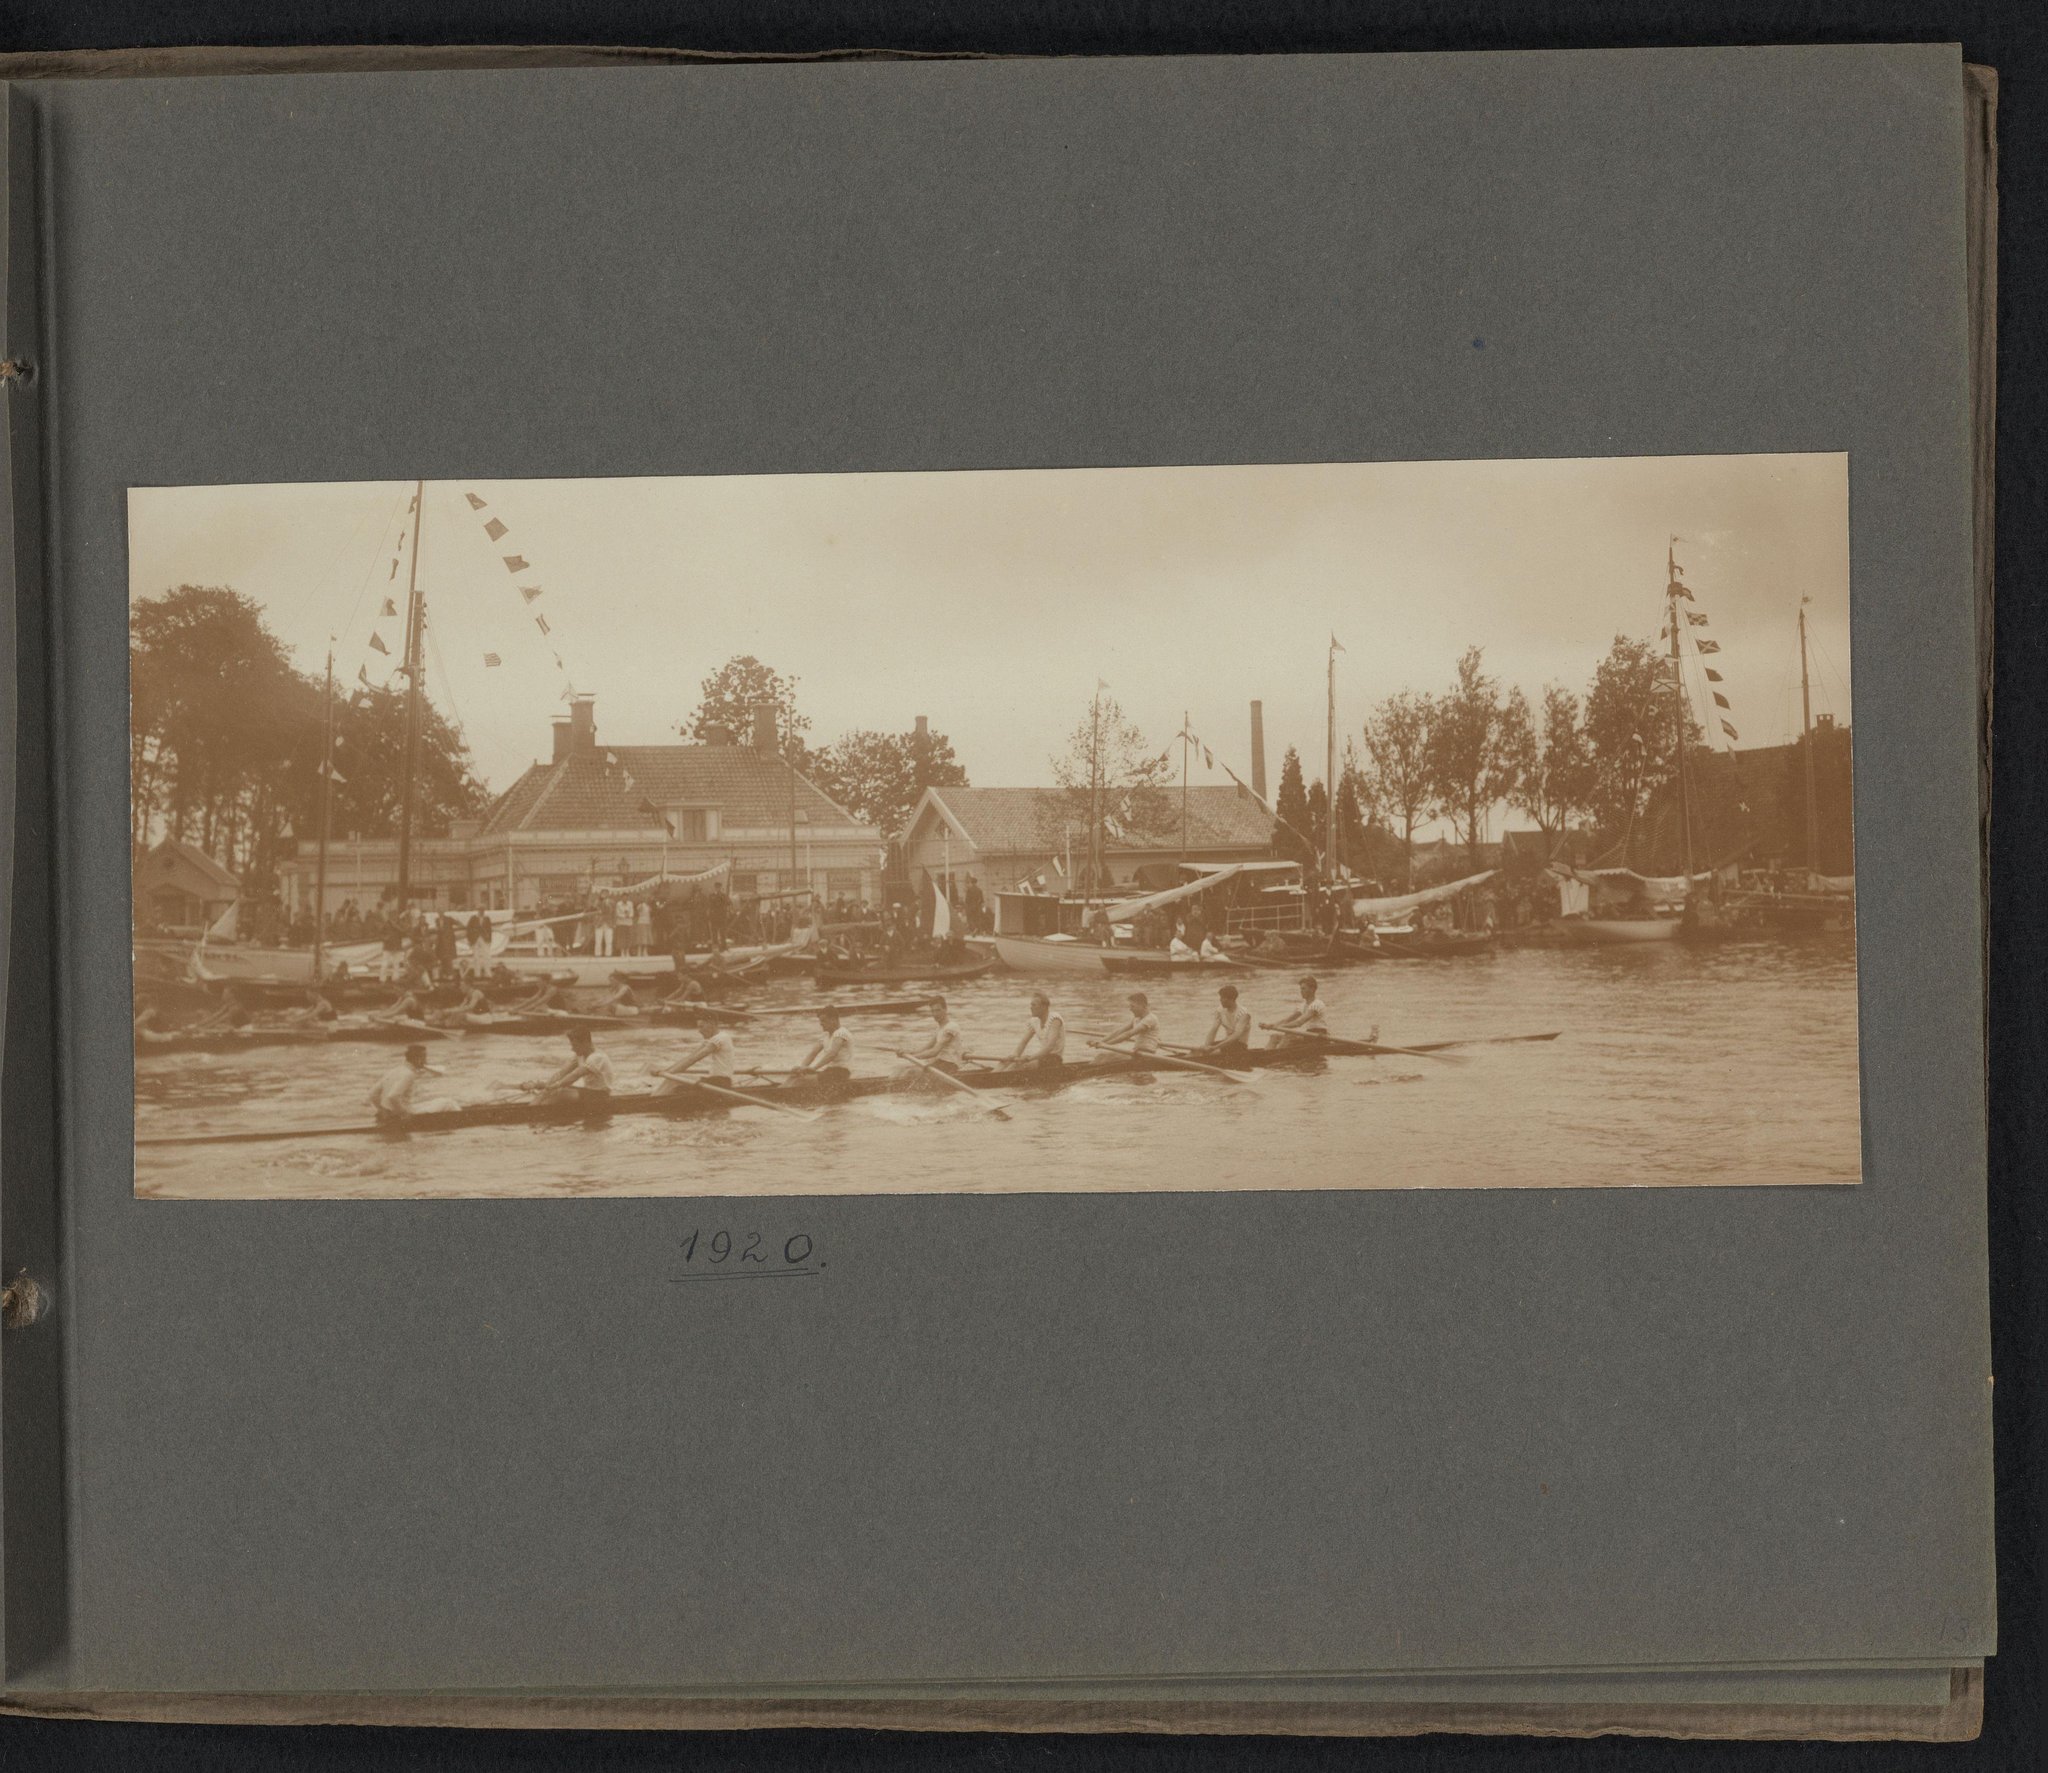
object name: photograph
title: 1920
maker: Anonymous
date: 1920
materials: paper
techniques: gelatin silver print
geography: netherlands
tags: rowing facing backward, pulling, rowing, canoeing, etc. (sport)